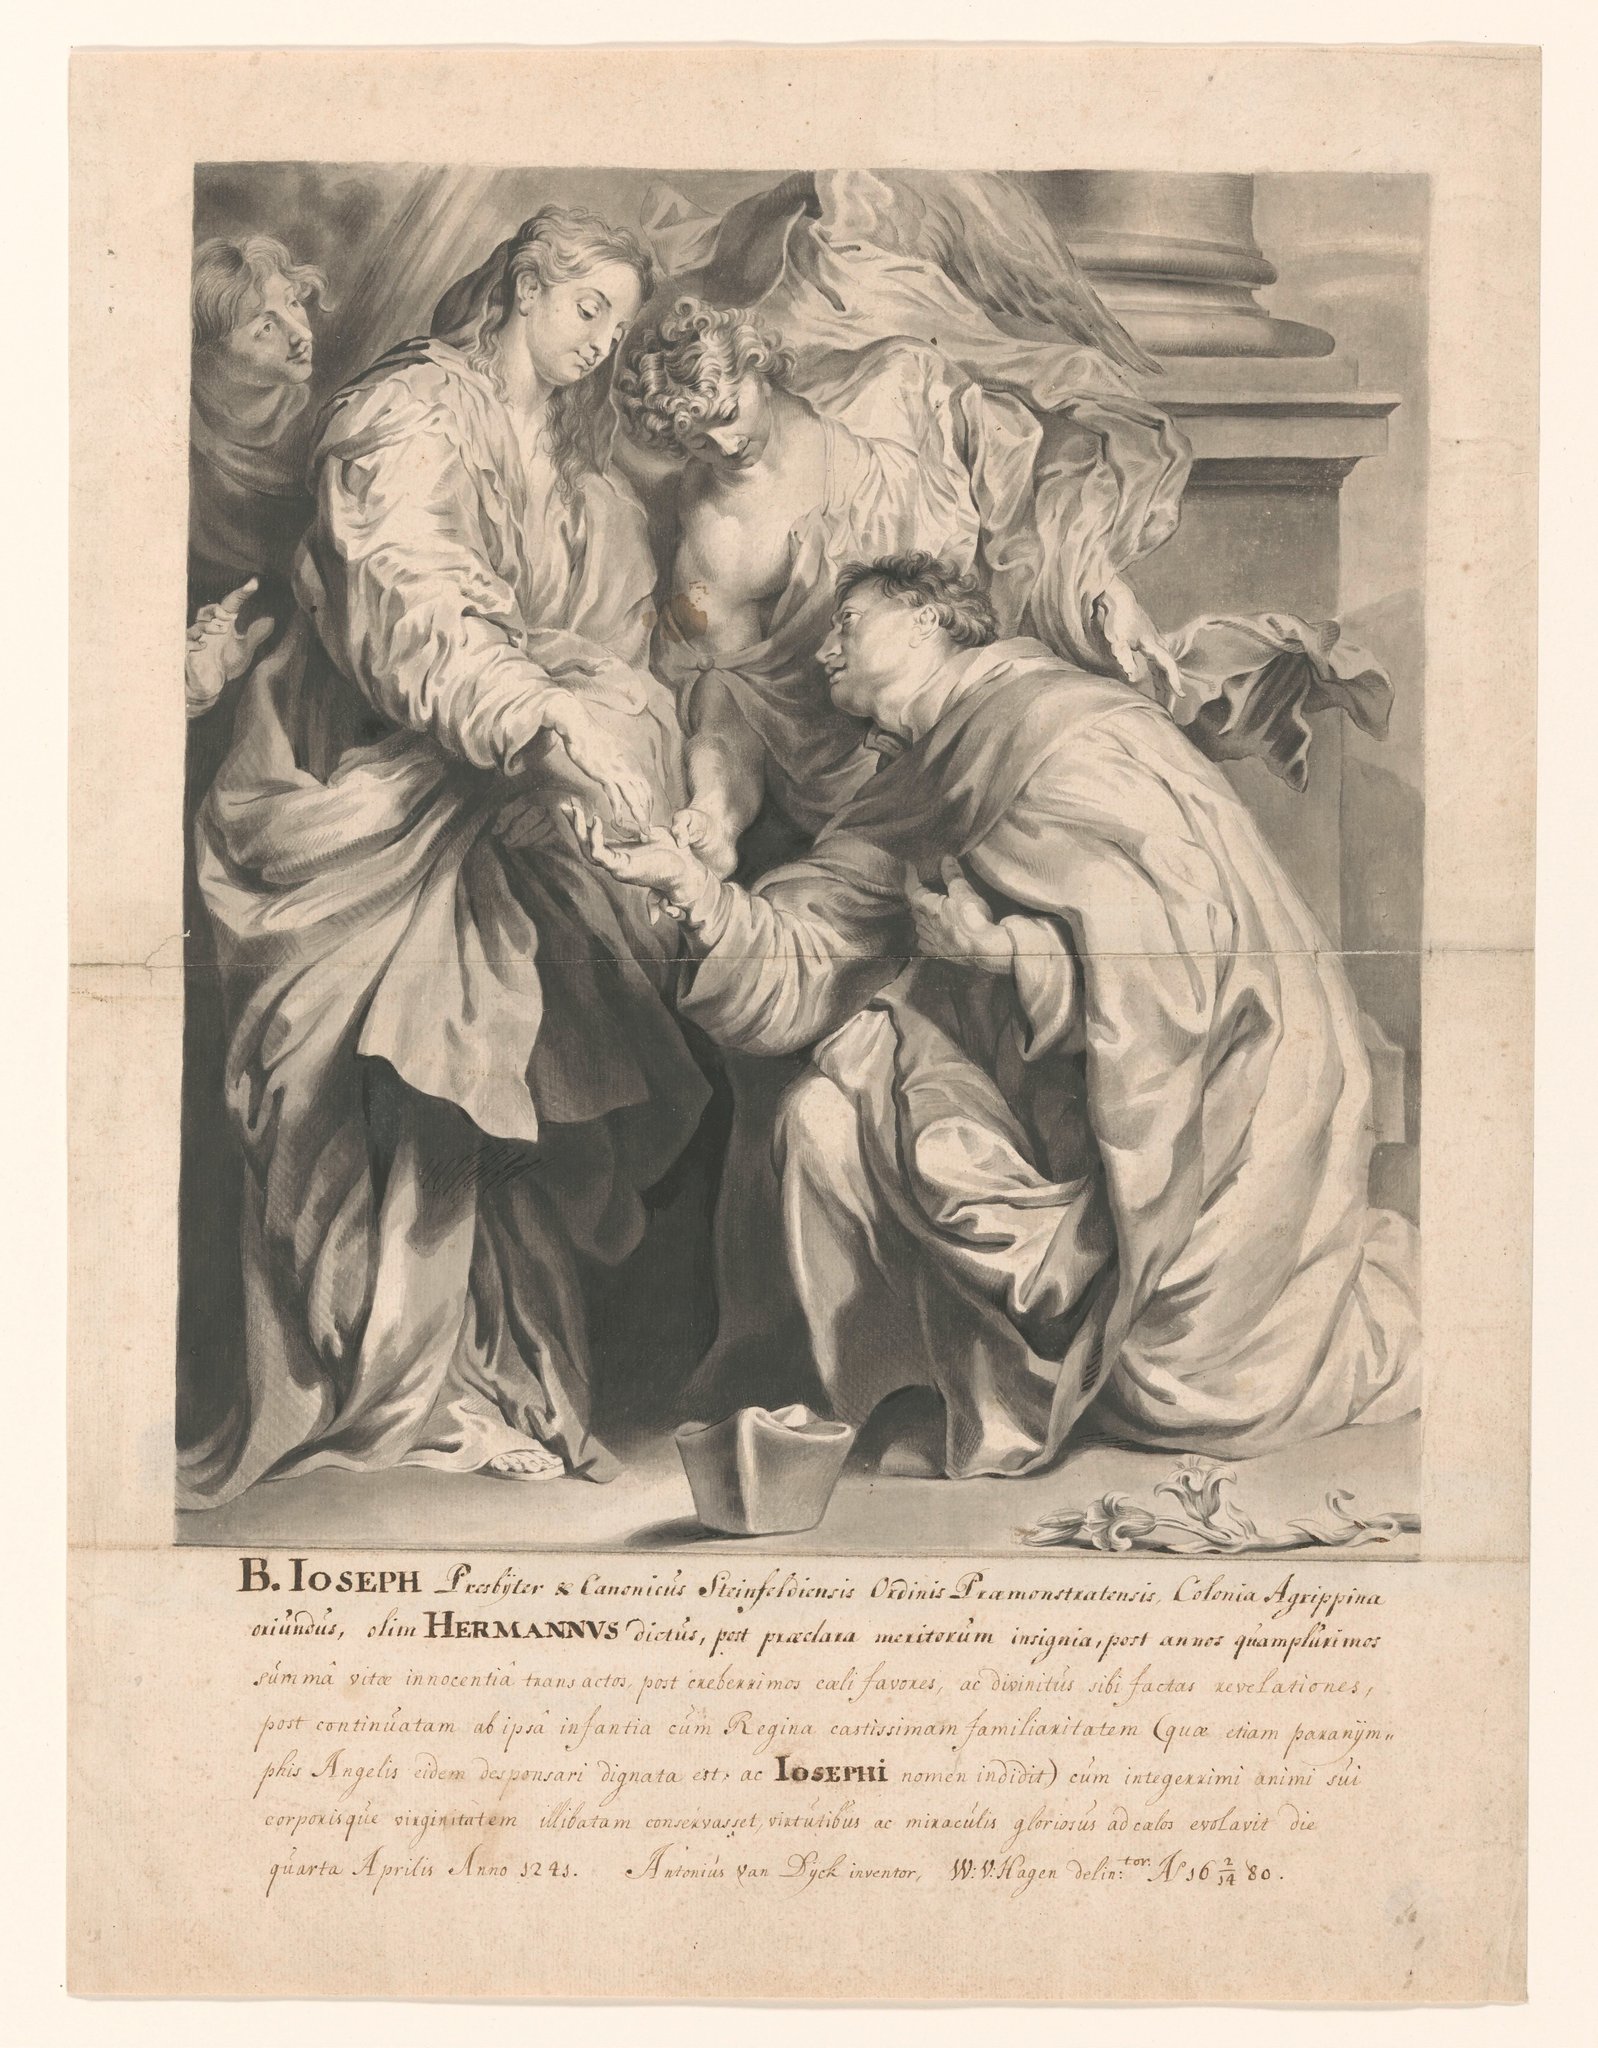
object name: drawing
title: St. Joseph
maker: witte van der hagen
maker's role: draughtsman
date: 1680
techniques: brush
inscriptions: signature and date: ‘W: V: Hagen 2 februari 1680’, caption